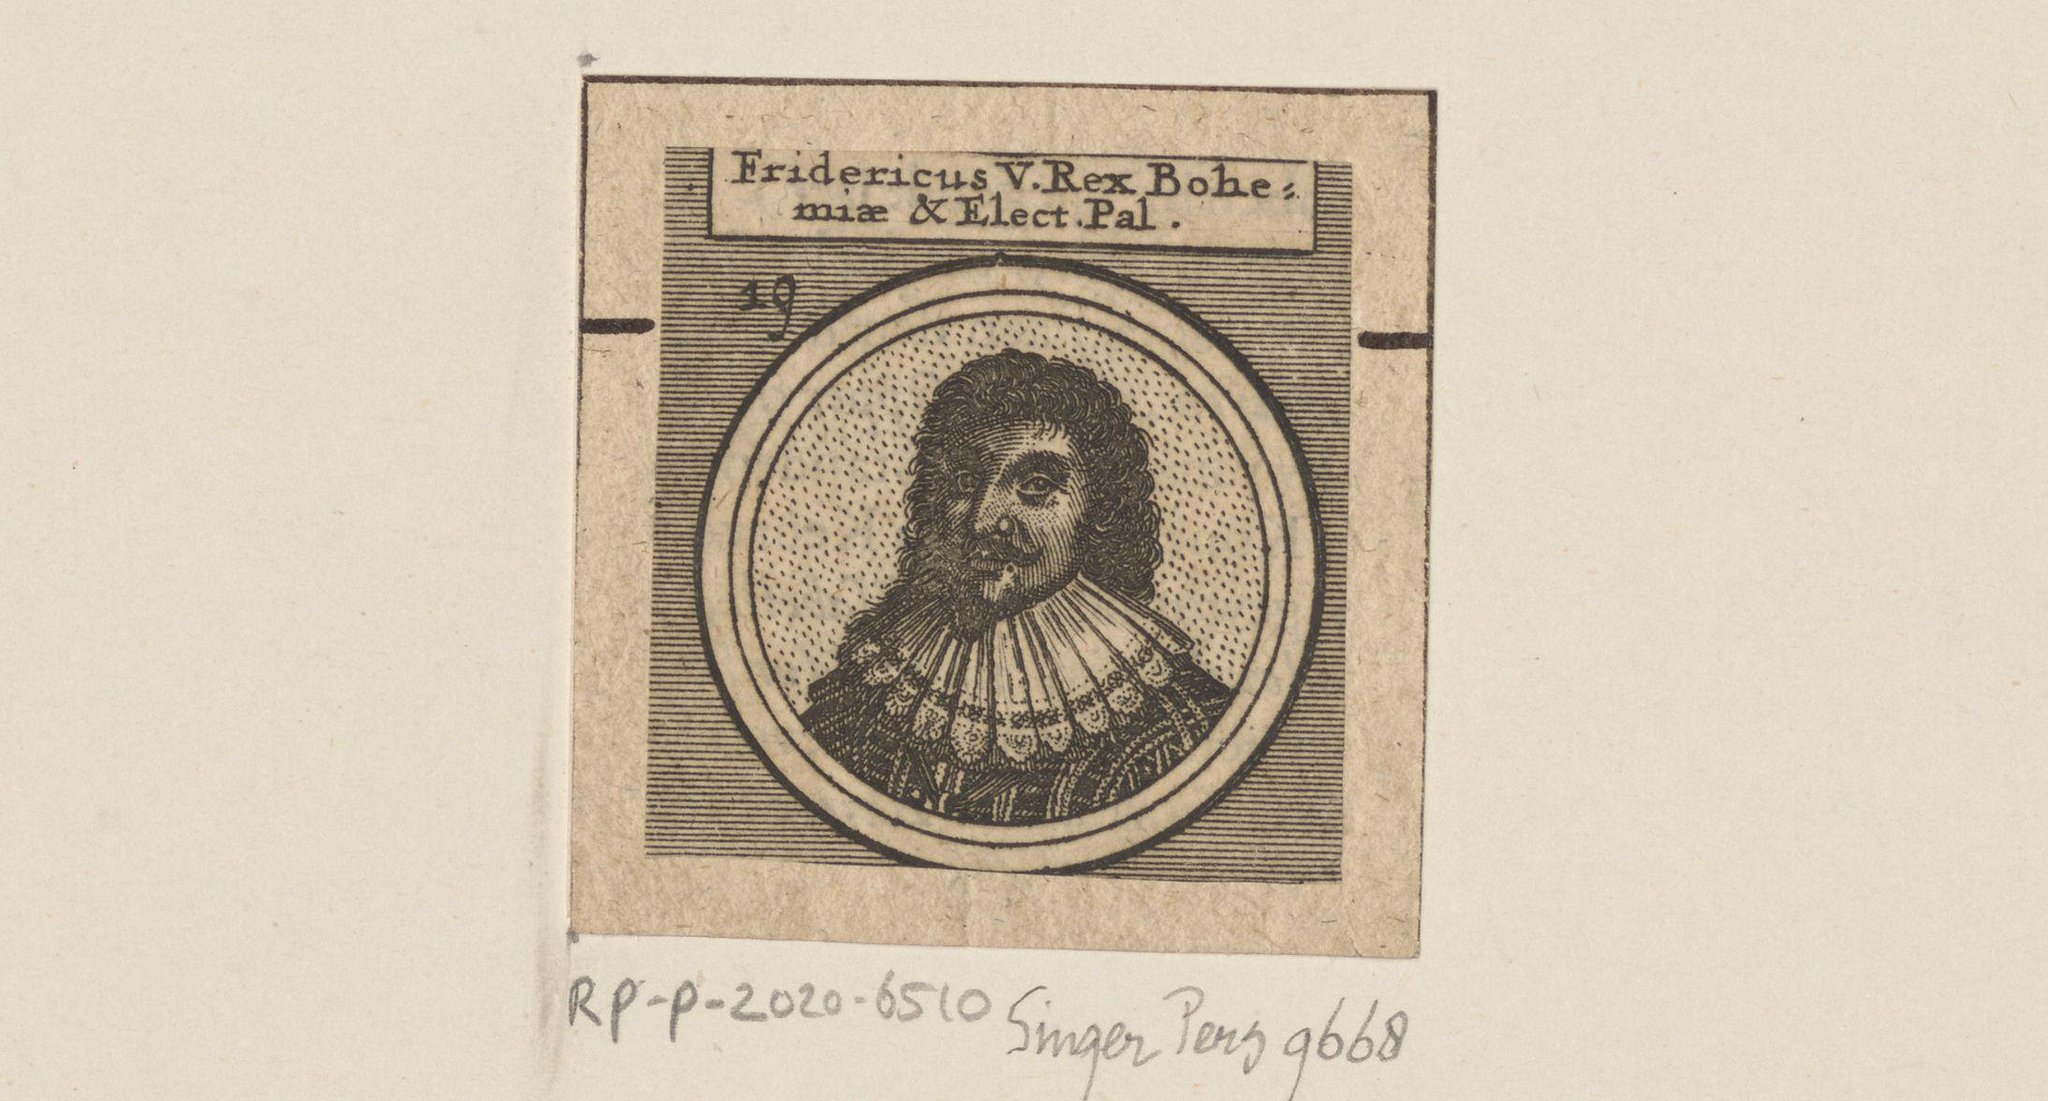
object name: book illustration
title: Portret van Frederik V van de Palts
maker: Anonymous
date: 1698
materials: paper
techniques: etching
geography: northern netherlands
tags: amberg, frederik v (keurvorst van de palts, koning van bohemen), historical persons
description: Prent waarschijnlijk uit: Gottfried, Johann Ludwig. Historische Kronyck (...). Leiden: Pieter van der Aa, 1698.